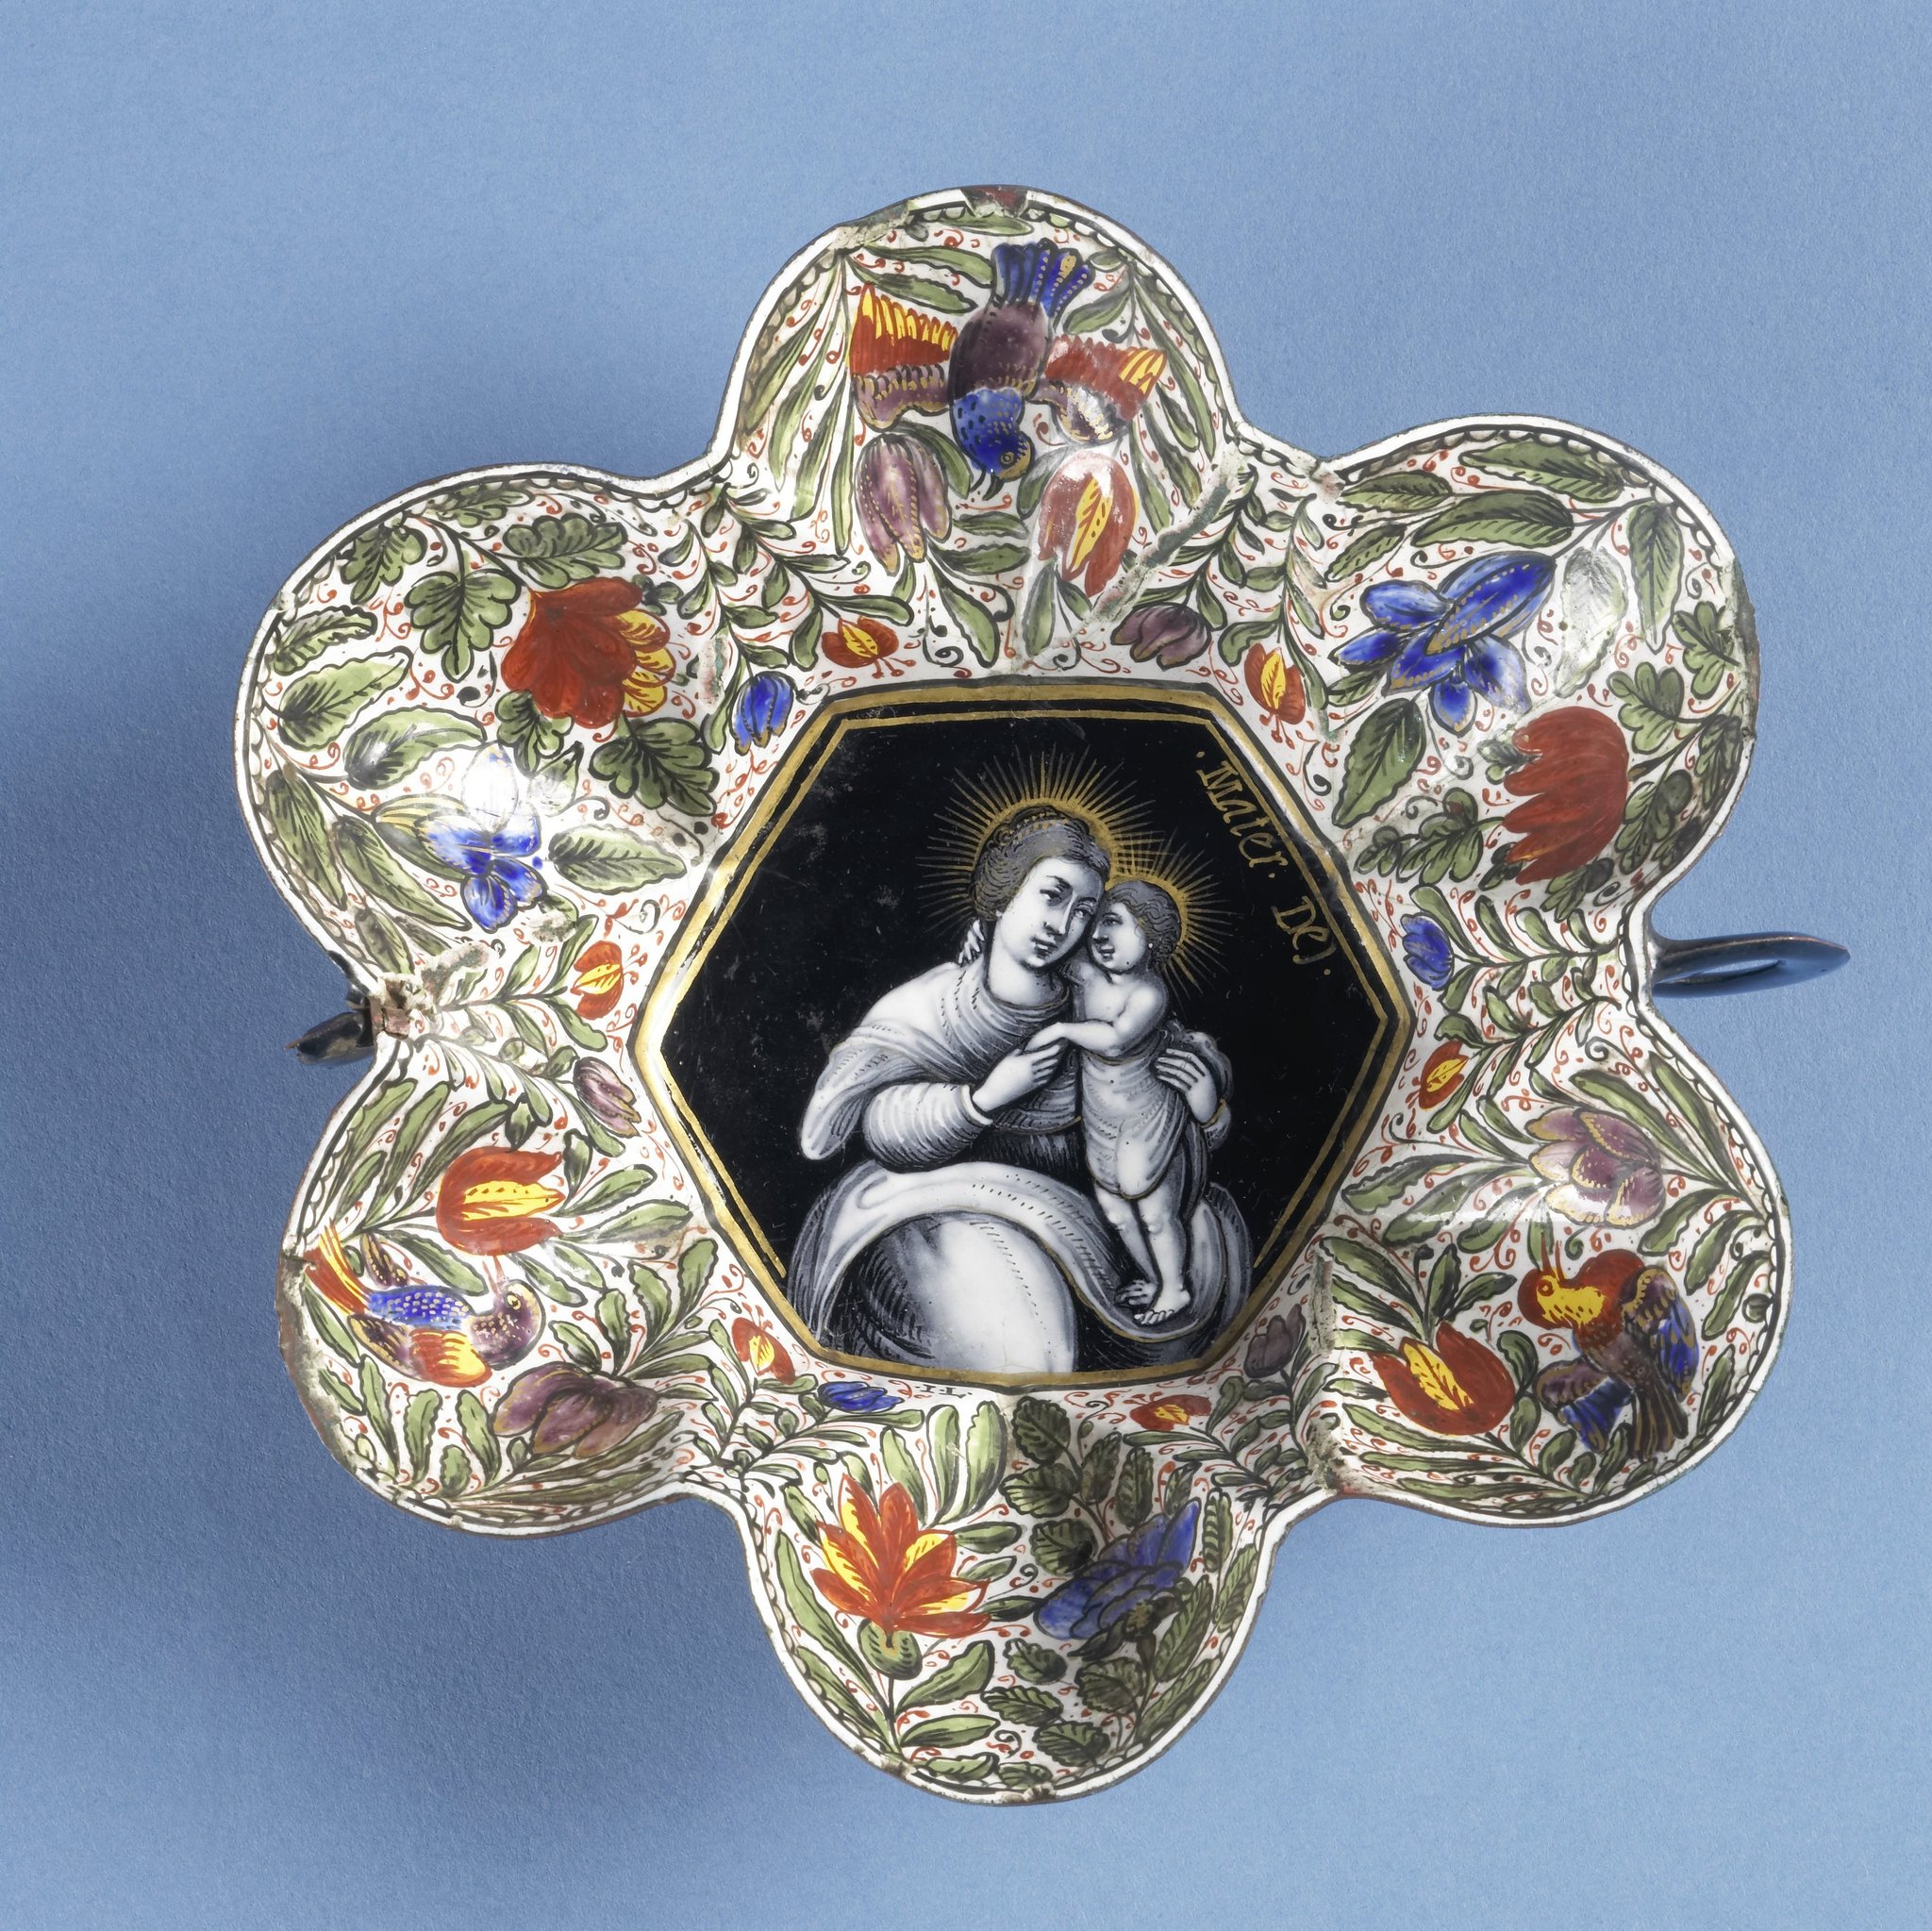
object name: bowl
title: Zeslobbige schotel van email met een voorstelling van Maria met Kind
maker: jean limosin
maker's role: emailleschilder, emailleur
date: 1600-1650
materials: copper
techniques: enamel, gilding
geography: limoges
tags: madonna: i.e. mary with the christ-child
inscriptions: inscription: ‘.Mater. Dei.’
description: Zeslobbige schotel versierd met email. In het midden in grisaille tegen een zwarte achtergrond Maria met Kind. De zeslobbige, opstaande rand is versierd met bladranken en bloemen in de kleuren geel, rood en blauw.